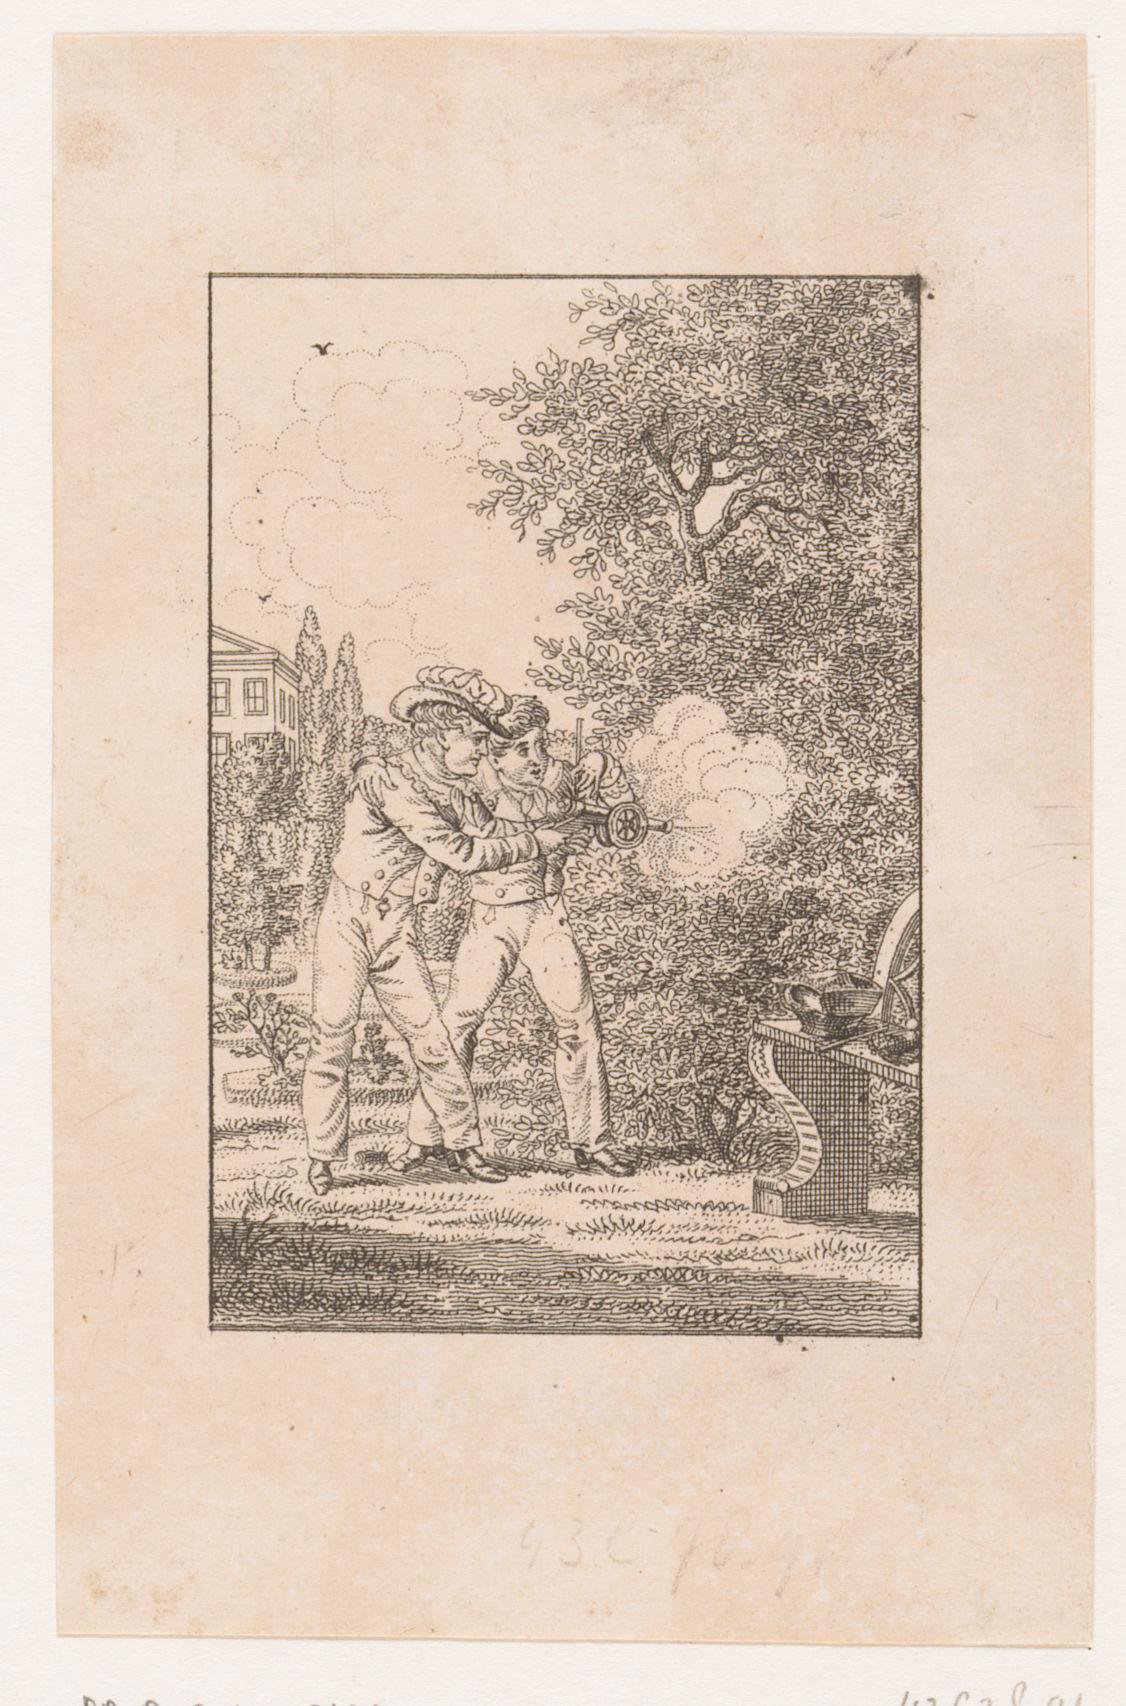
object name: print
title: Twee jongens met een speelgoedkanon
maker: Anonymous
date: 1750-1850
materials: paper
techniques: etching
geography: germany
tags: miniature imitations (children's games and plays), firearms: cannon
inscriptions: collector's mark: Lugt 2228